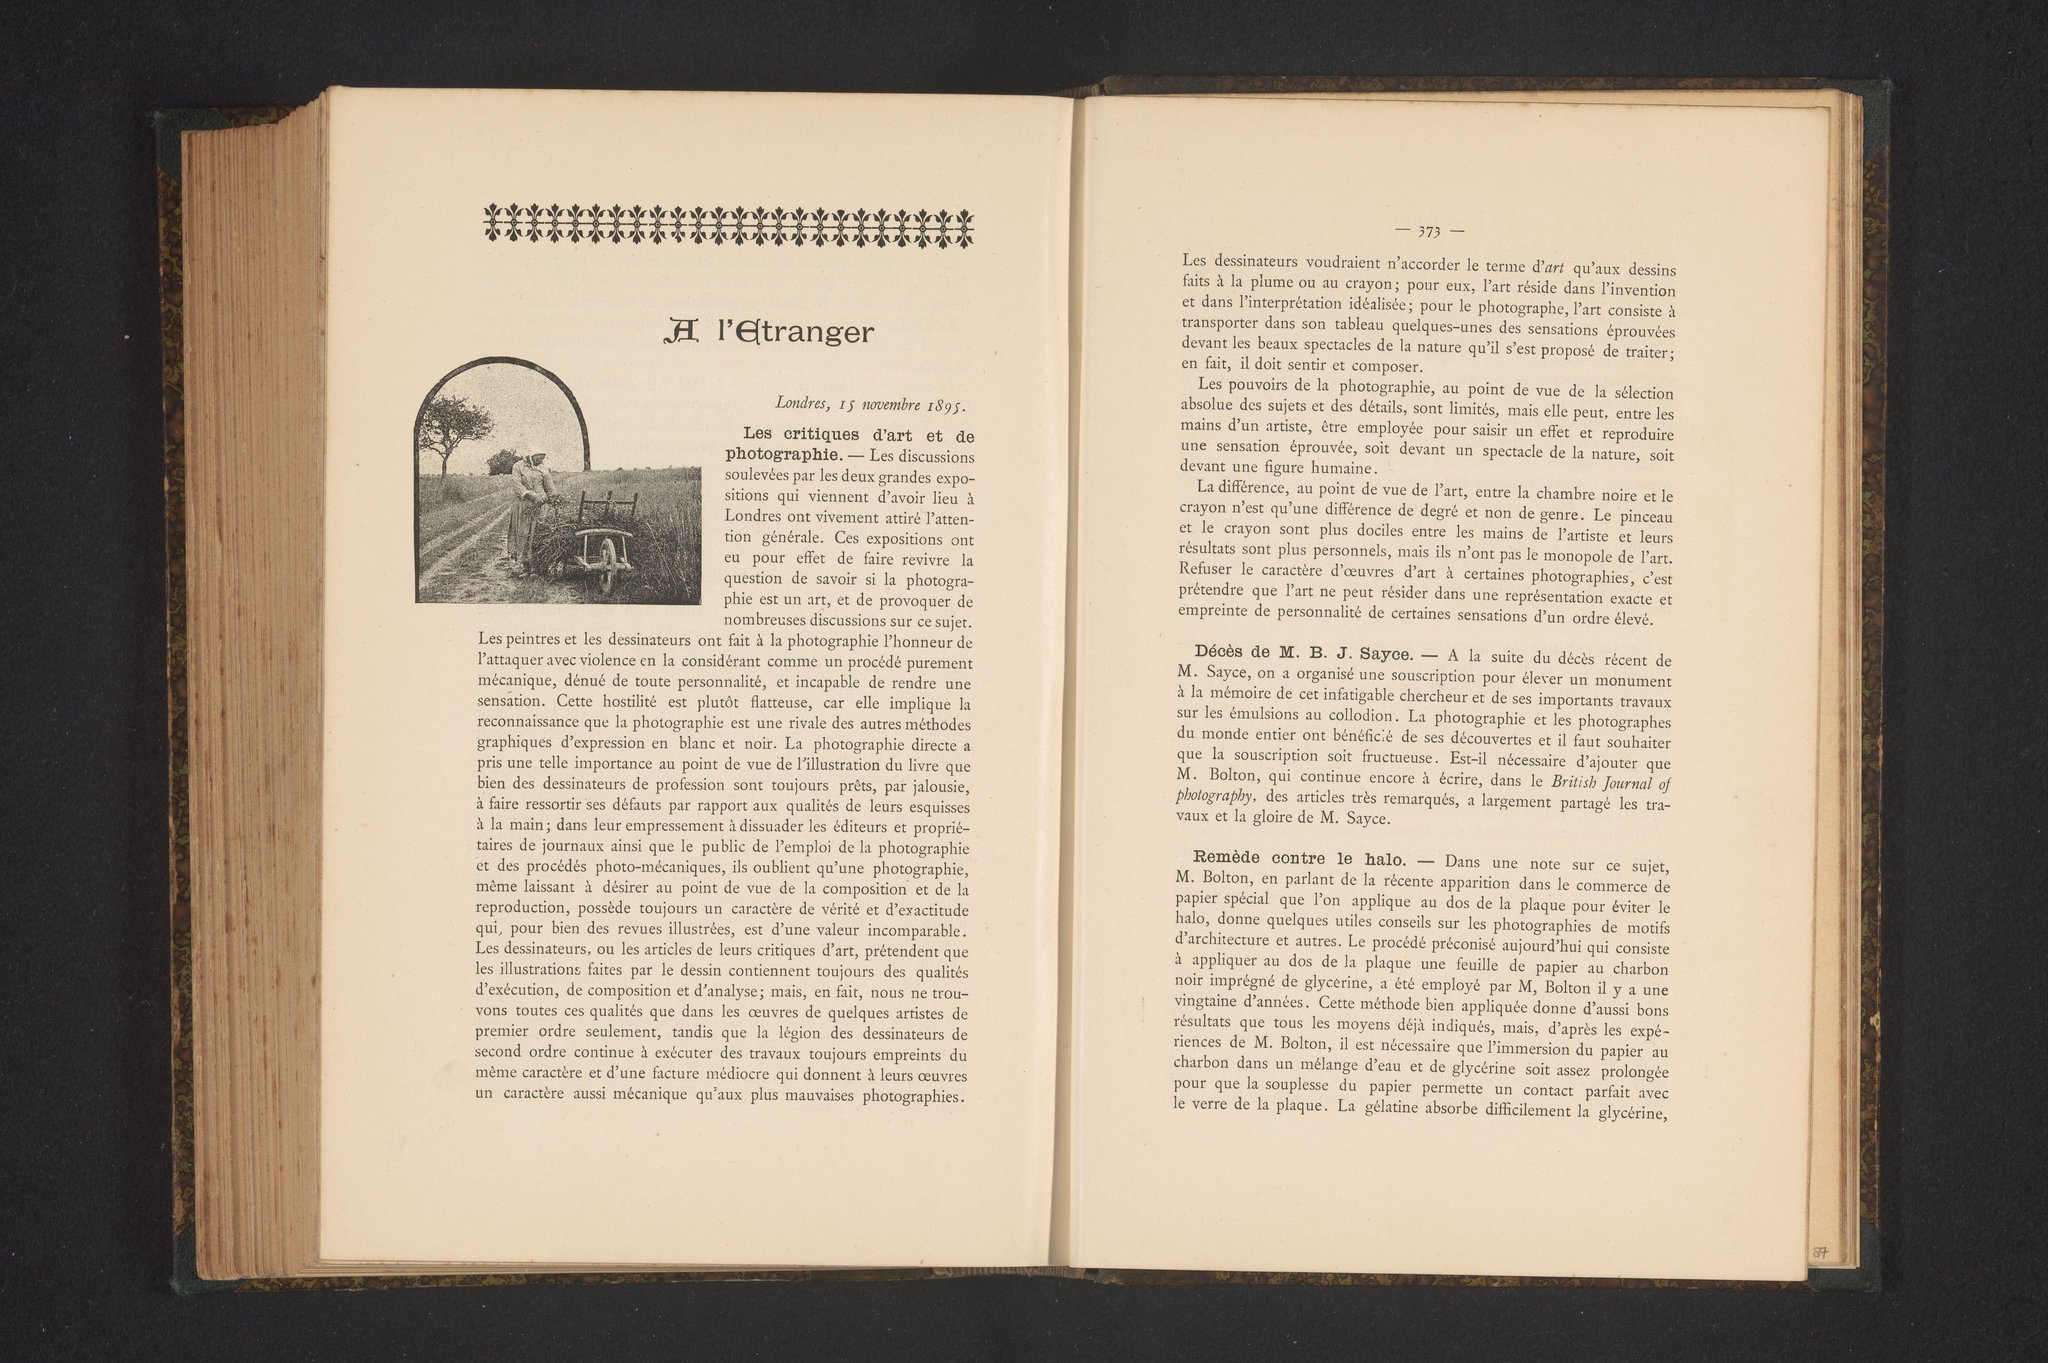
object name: photomechanical print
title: Boerin met een kruiwagen met hooi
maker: Anonymous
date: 1890-1895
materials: paper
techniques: photograph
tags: agricultural products and by-products: hay, farmers - aa - female farmer, farmer's wife, wheelbarrow